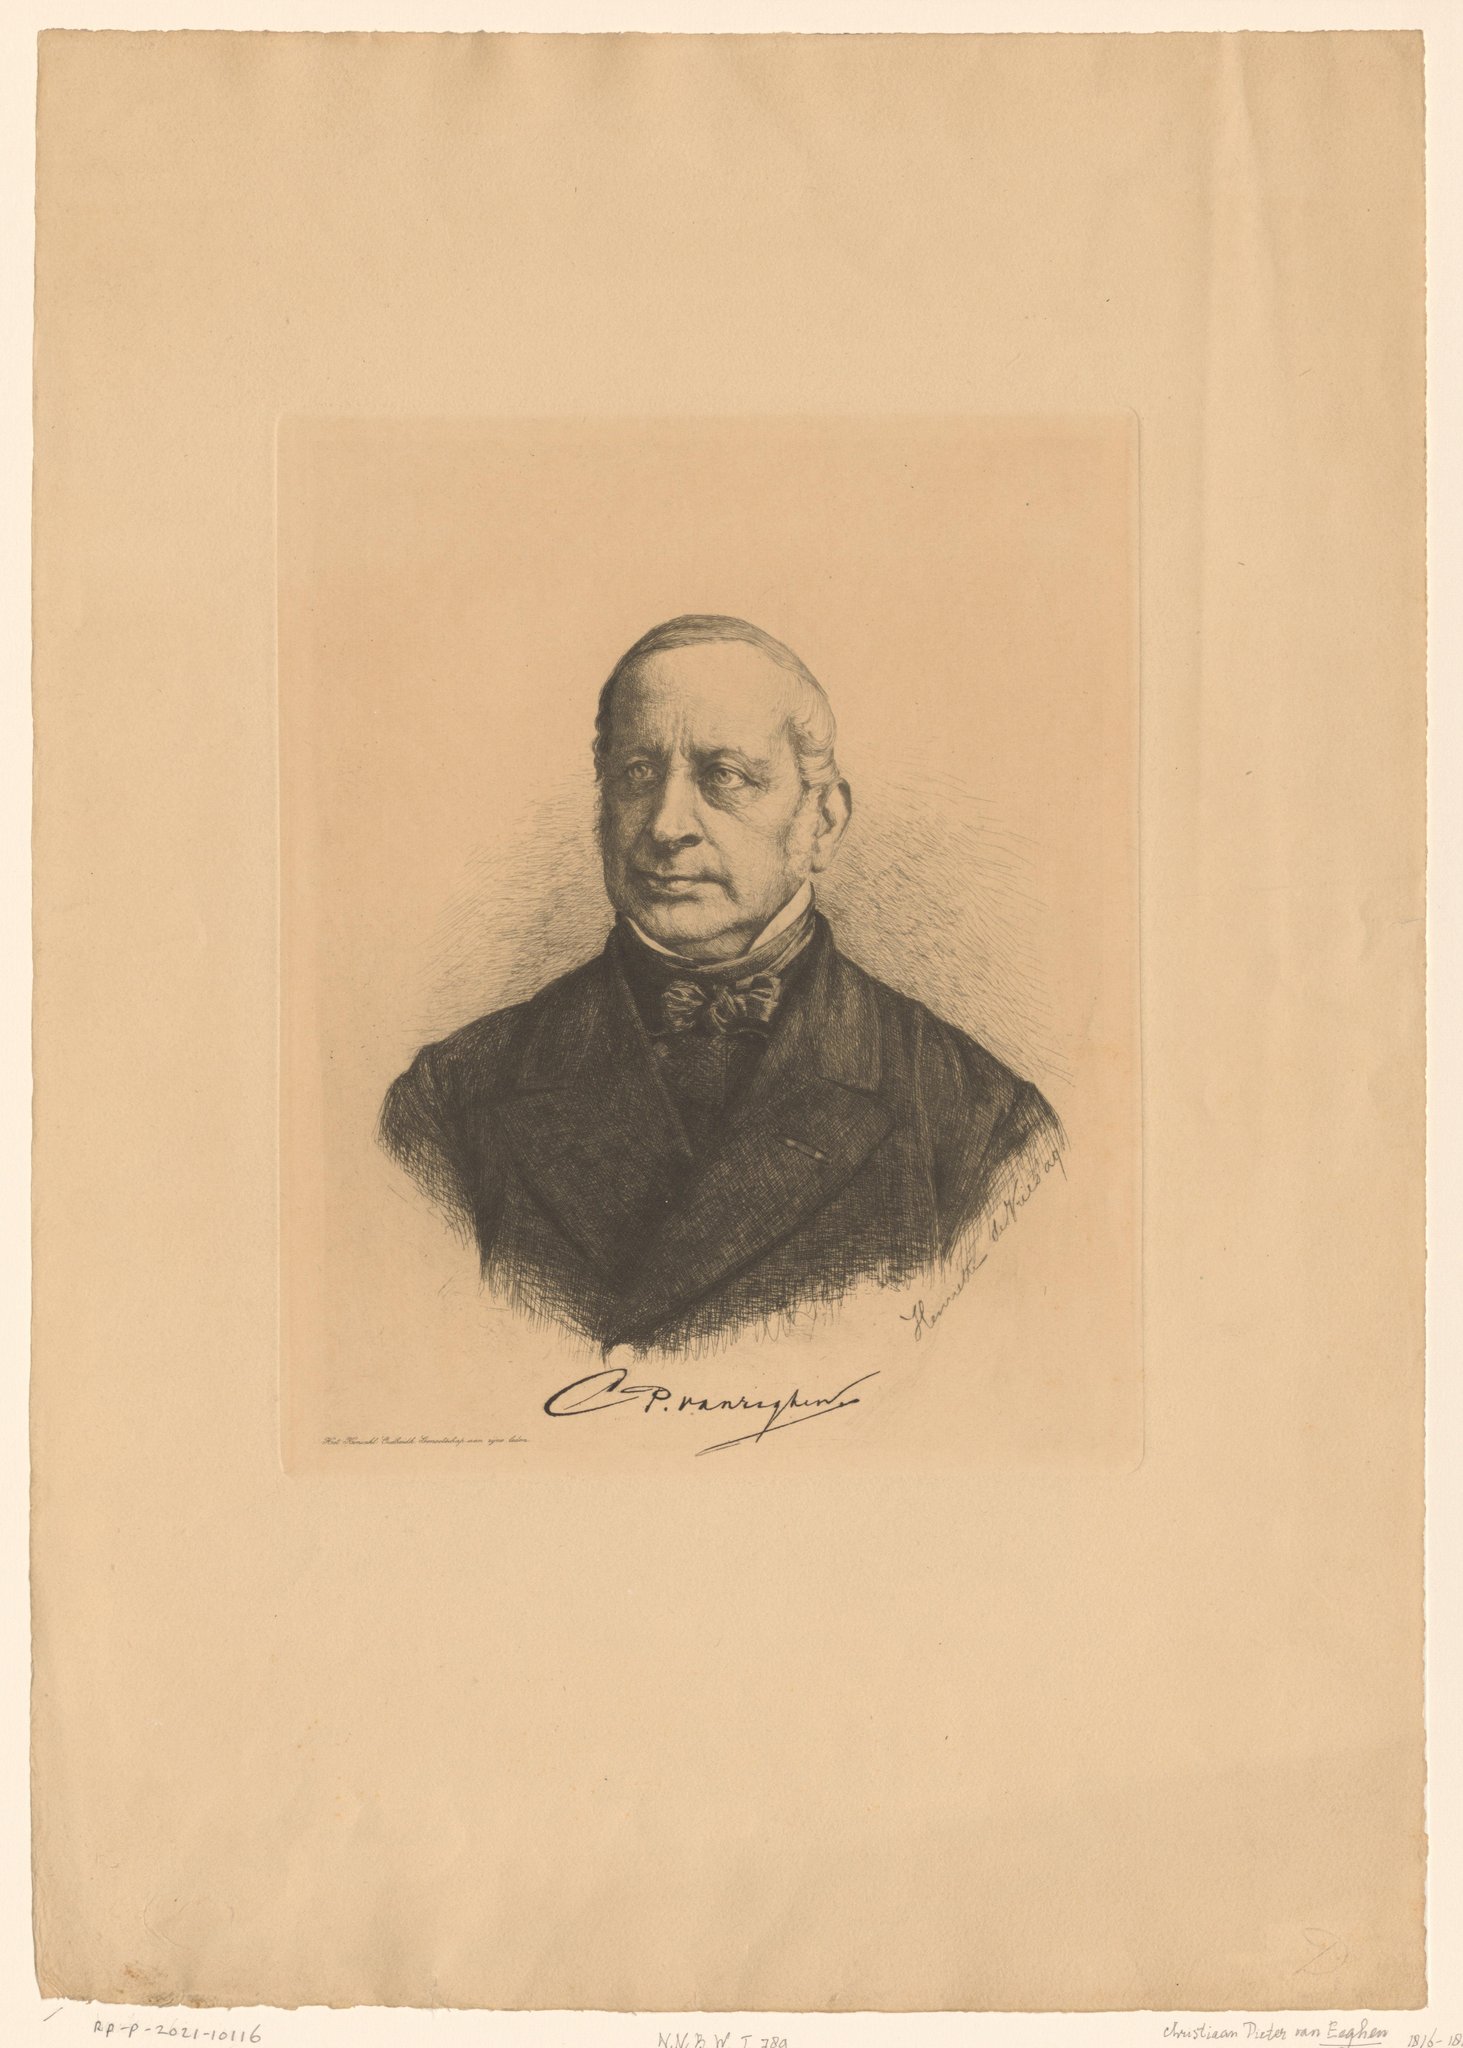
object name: print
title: Portret van Christiaan Pieter van Eeghen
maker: henriëtte de vries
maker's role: draughtsman, print maker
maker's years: 1867-1942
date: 1880-1898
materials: paper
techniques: etching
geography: netherlands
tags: historical persons, art collector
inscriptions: collector's mark: Lugt 2228, inscription: ‘uit kelderdépôt 2002’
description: Linksonder staat: Het Koninkl. Oudheidk: Genootschap aan zijne leden.